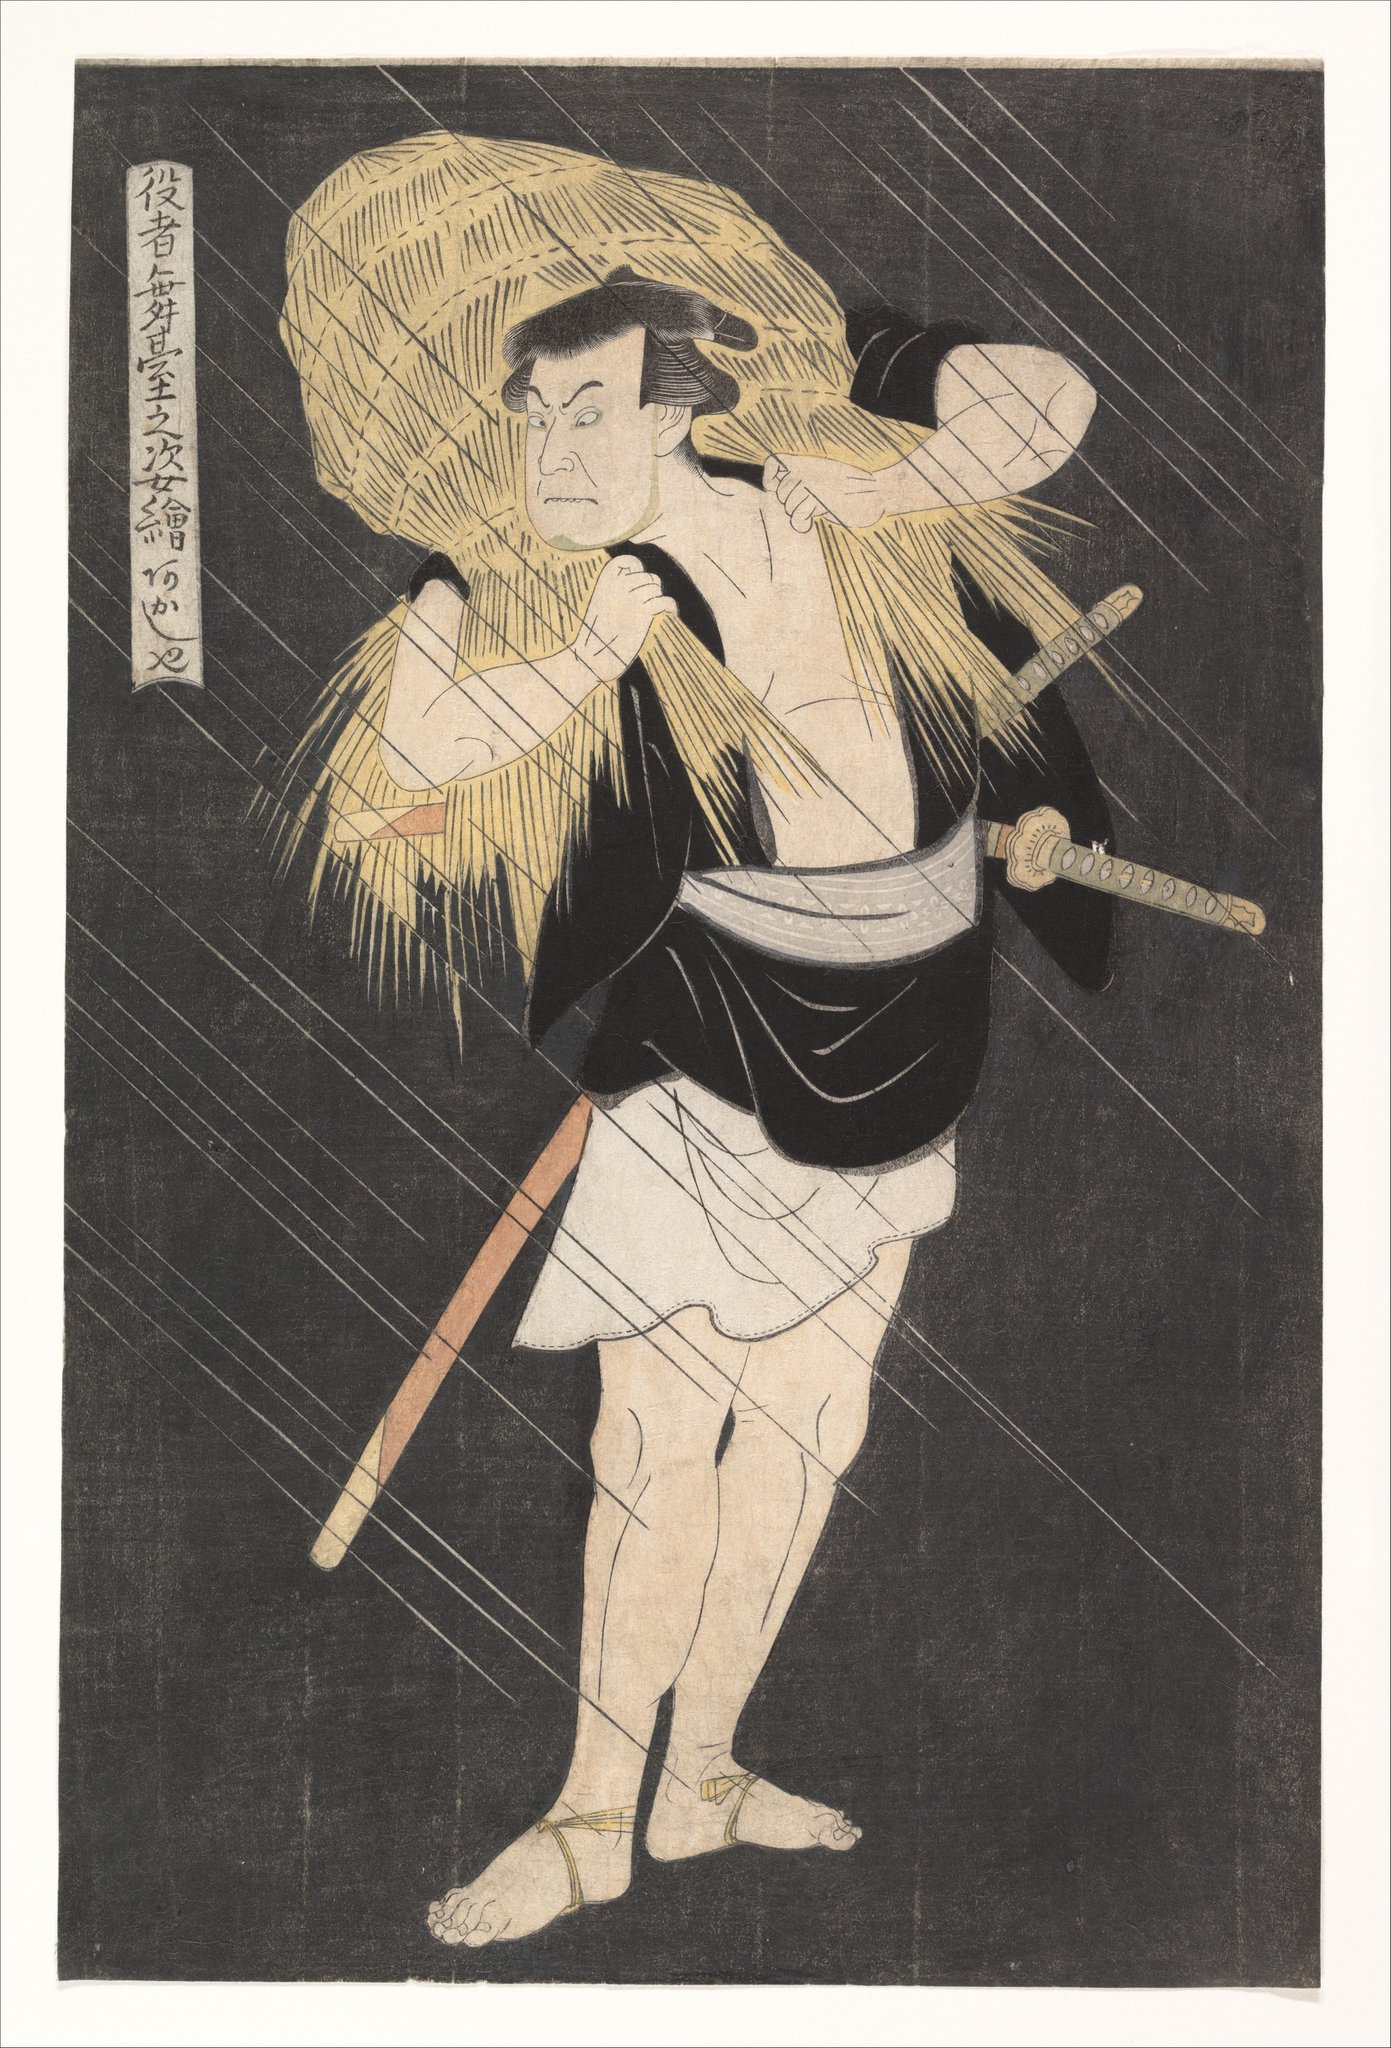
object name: print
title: The Actor Ōtani Tomoemon in the Role of Ono Sadakurō, from the series Image of Actors on Stage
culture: japanese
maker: utagawa toyokuni i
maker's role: artist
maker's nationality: japanese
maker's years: 1769-1825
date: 1795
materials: ink, paper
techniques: woodblock print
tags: swords,men,actors